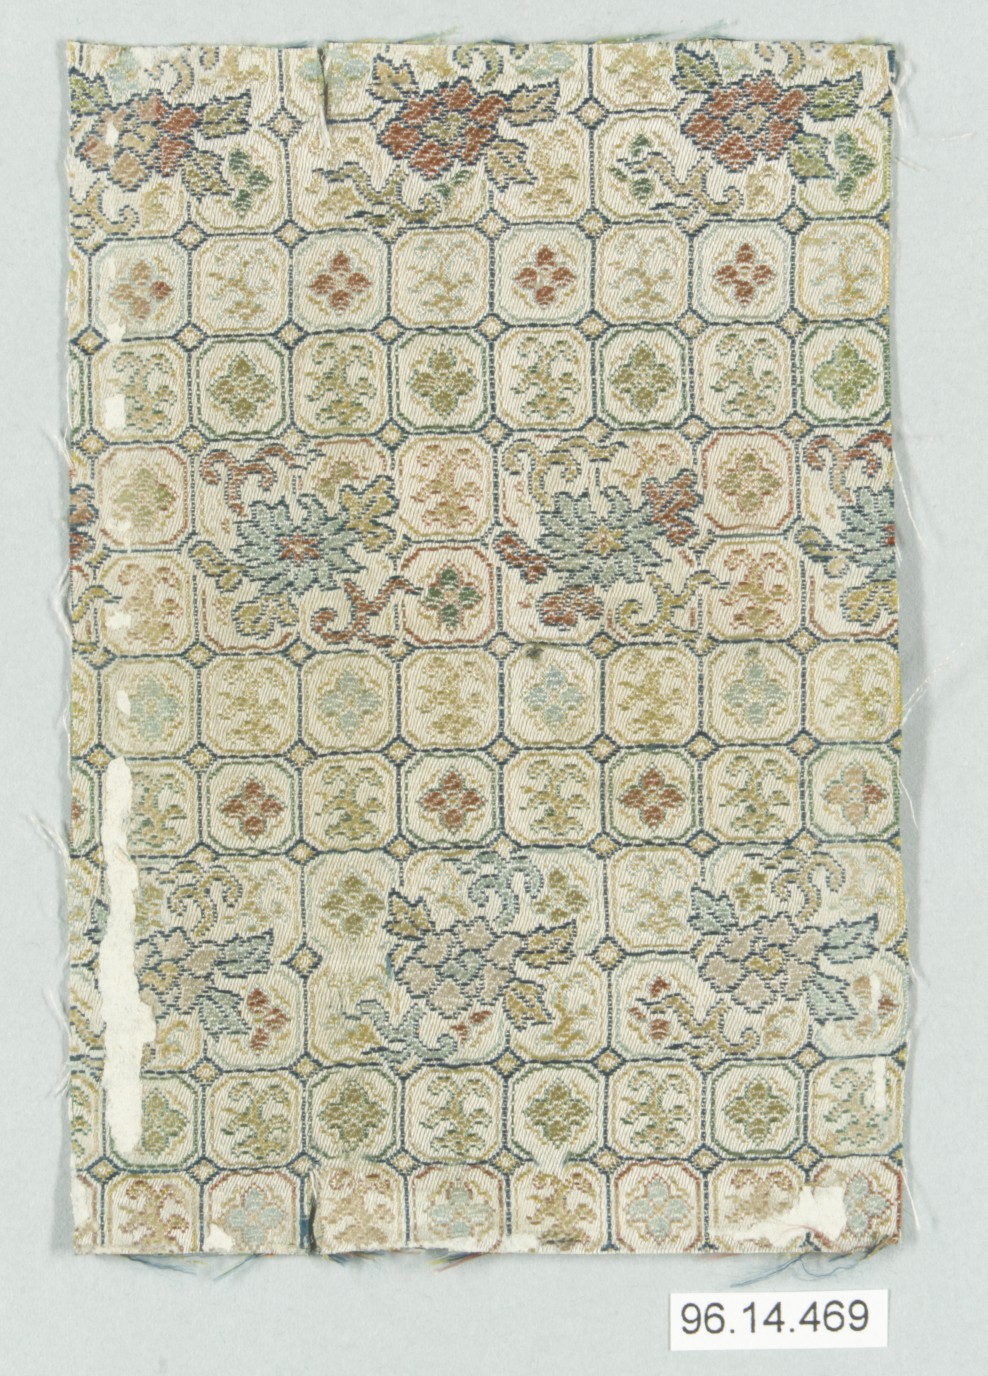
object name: piece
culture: japanese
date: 1801-1900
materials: silk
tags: leaves